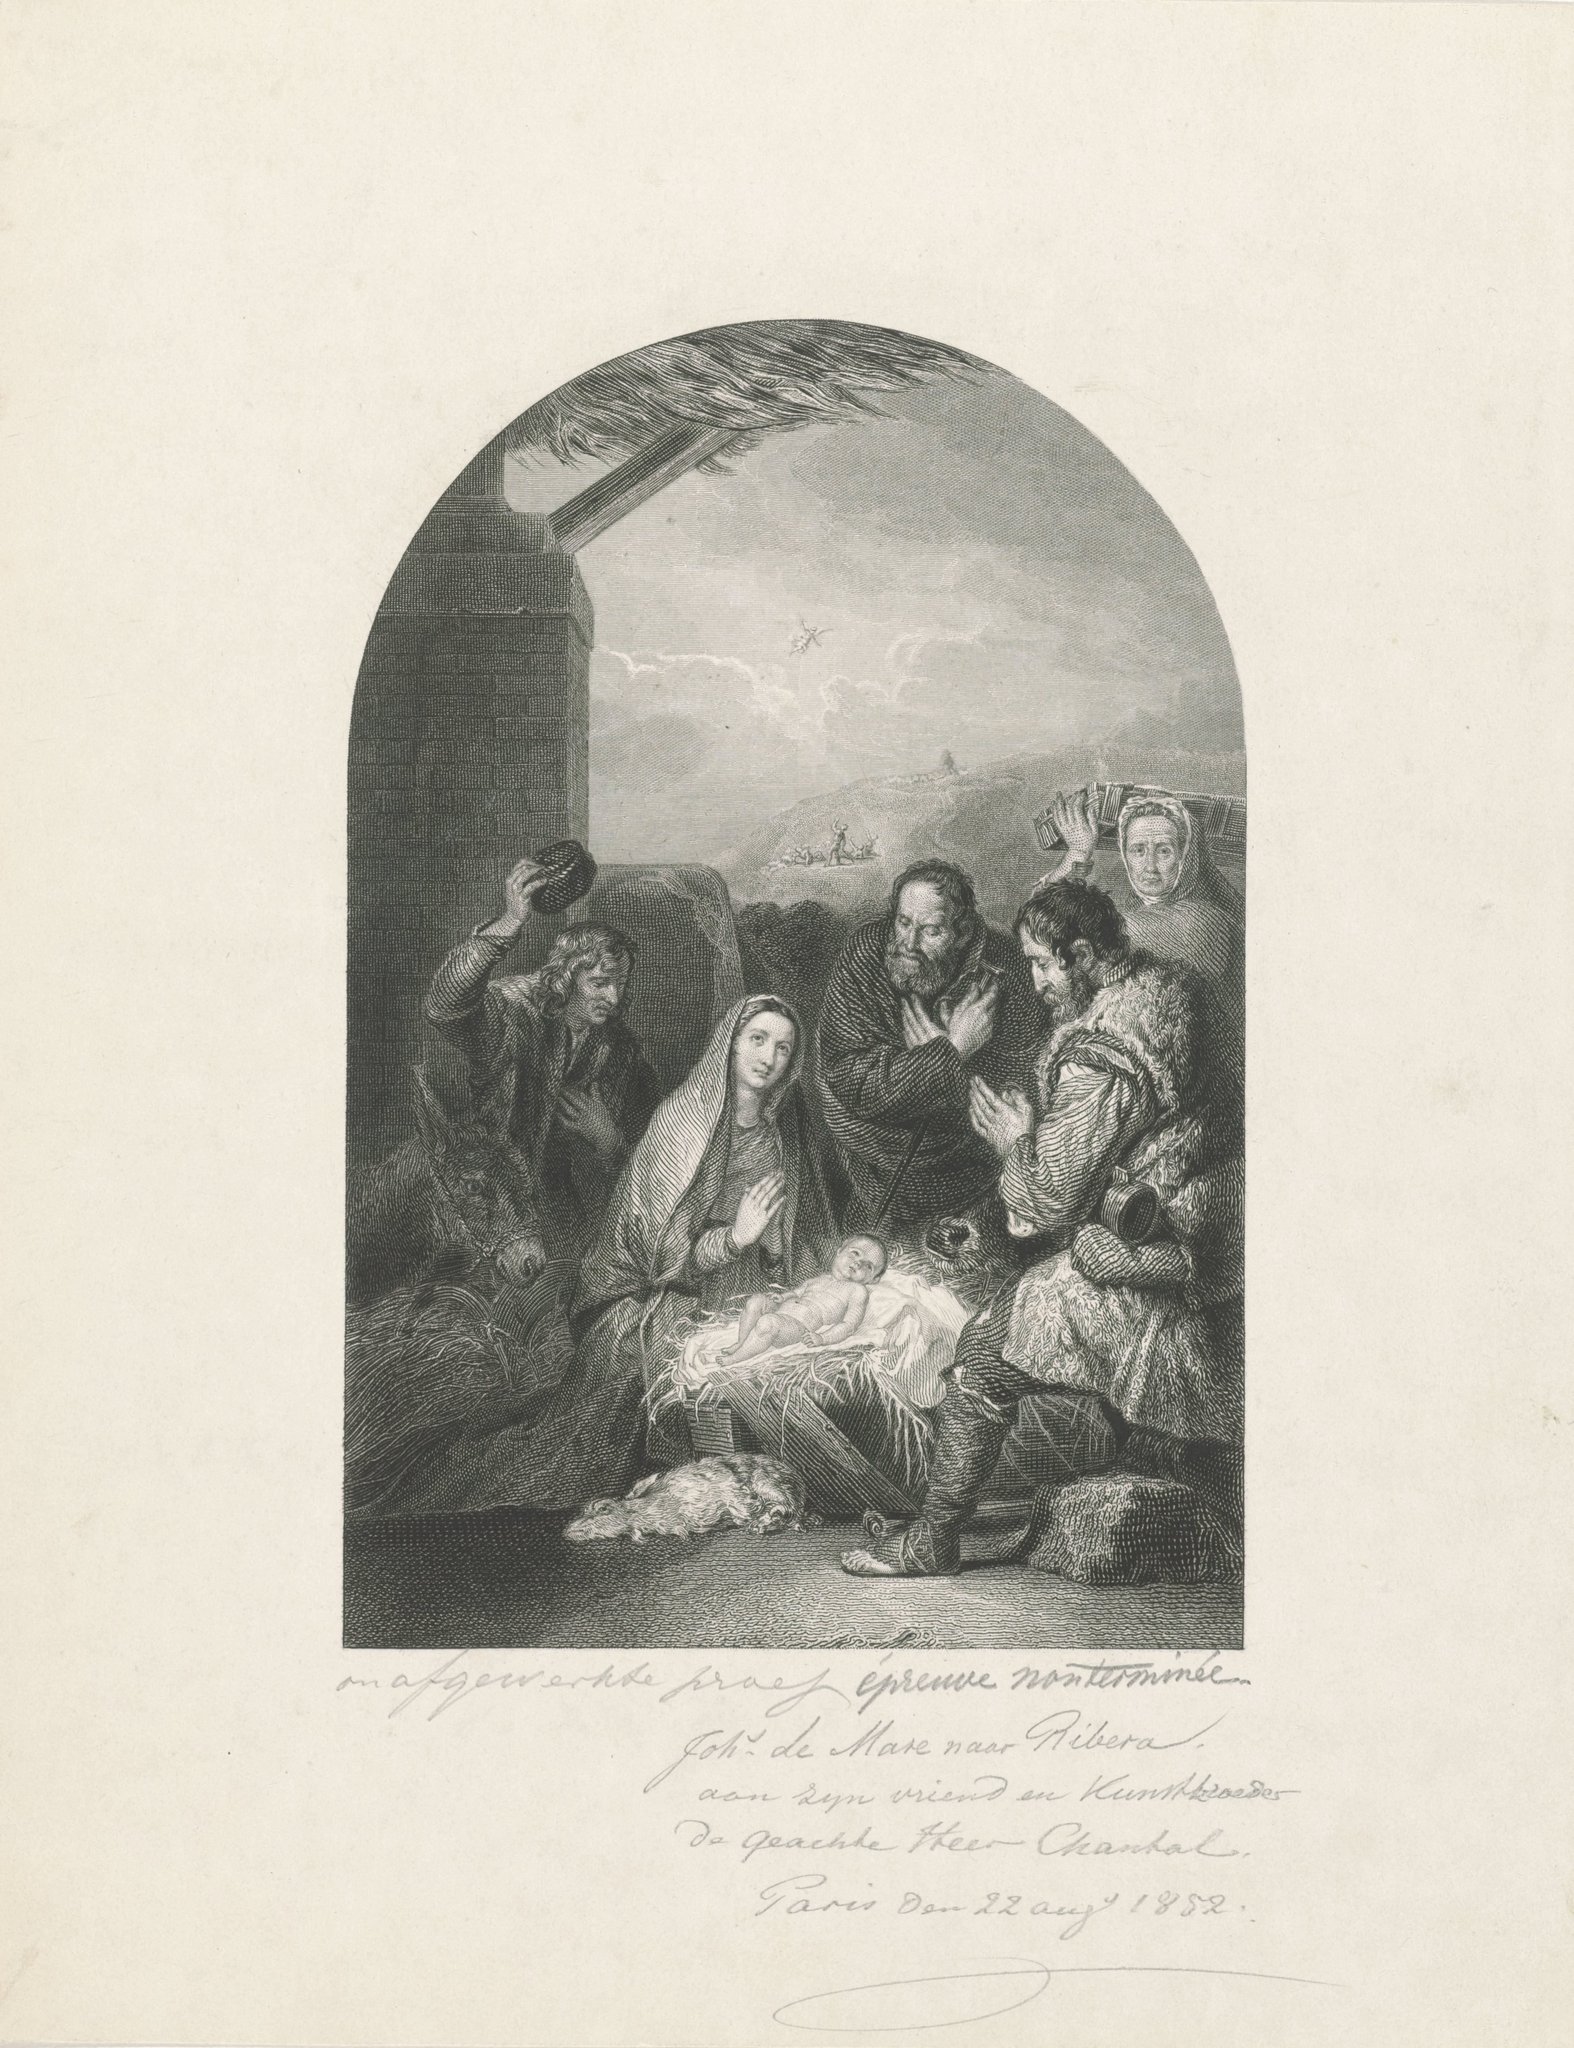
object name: print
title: Aanbidding door de herders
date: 1816-1852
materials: paper, pencil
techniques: engraving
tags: adoration of the christ-child by the shepherds; mary and joseph present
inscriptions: collector's mark: Lugt 2228, inscription: ‘onafgewerkte proef épreuve nonterminée/ Joh. de Mare naar Ribera/ aan zijn vriend en kunstbroeder/ de geachte Heer Chantal/ Paris den 22 aug. 1852’